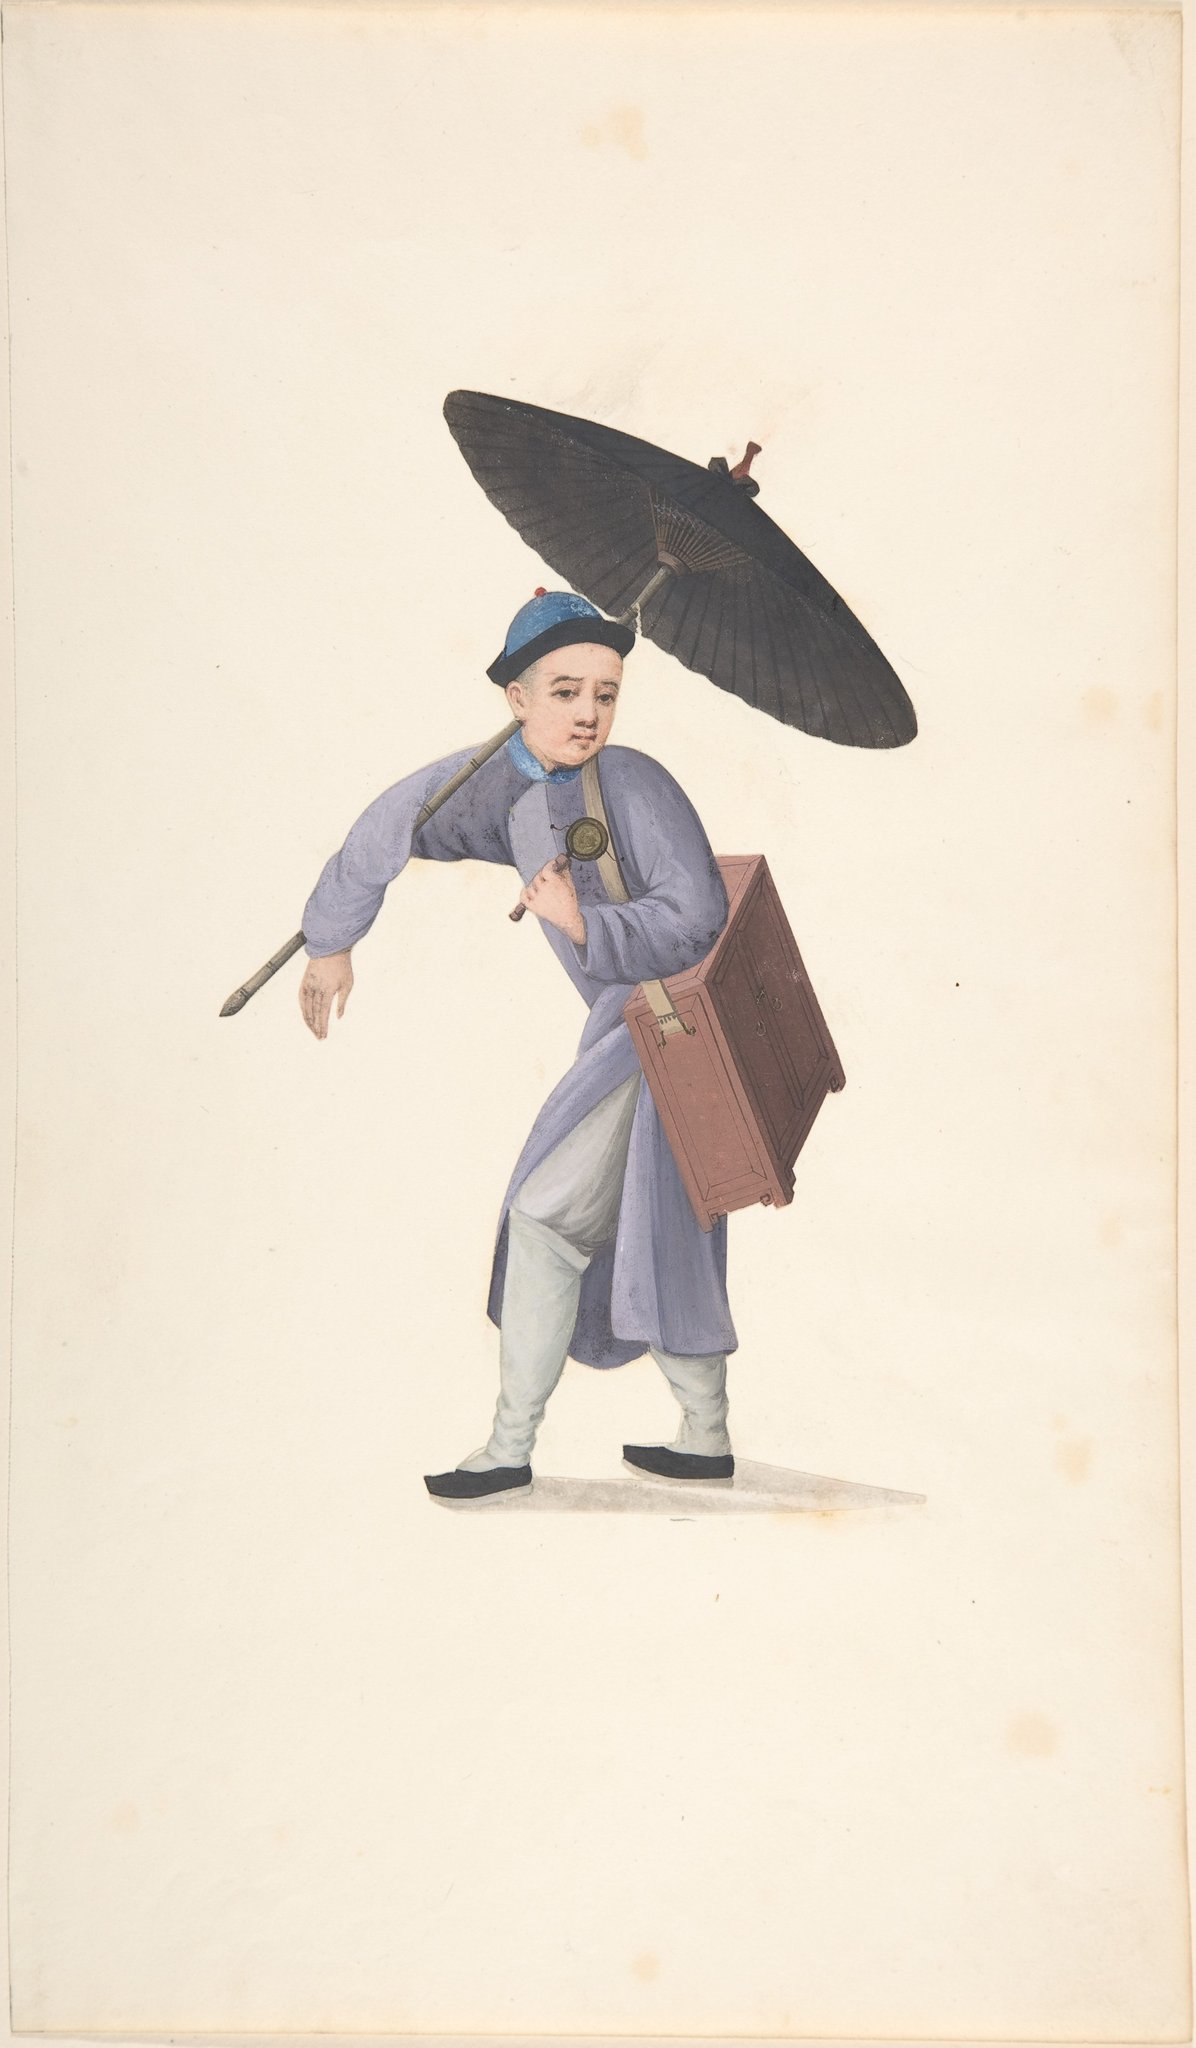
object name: drawing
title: Chinese Man with Parasol, Rattle and Box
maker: anonymous, chinese, 19th century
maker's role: artist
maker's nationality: chinese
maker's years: 1800-1900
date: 1801-1900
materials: gouache, watercolor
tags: musical instruments,men